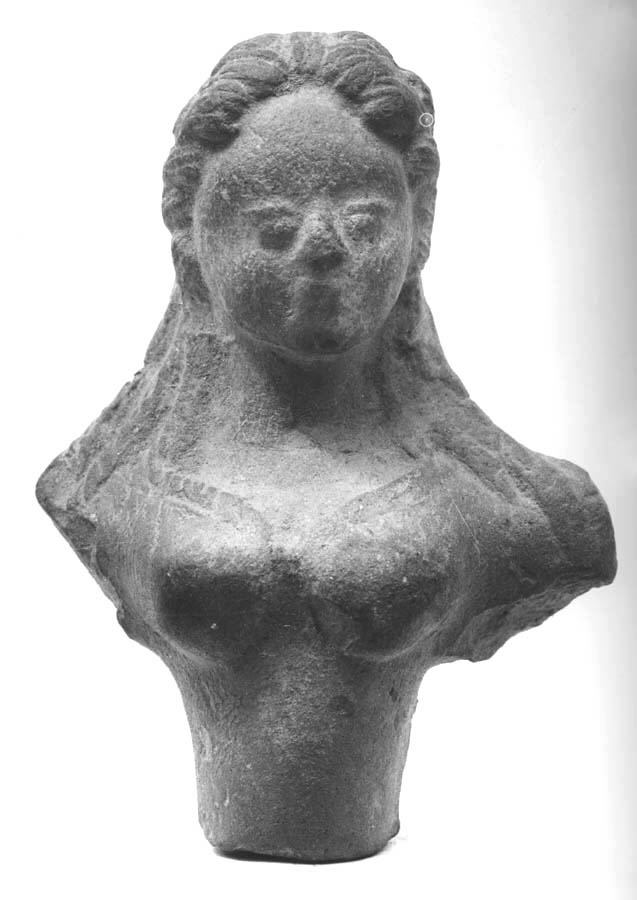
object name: bust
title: Bust of a Woman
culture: indian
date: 101-300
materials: terracotta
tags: shunga,women